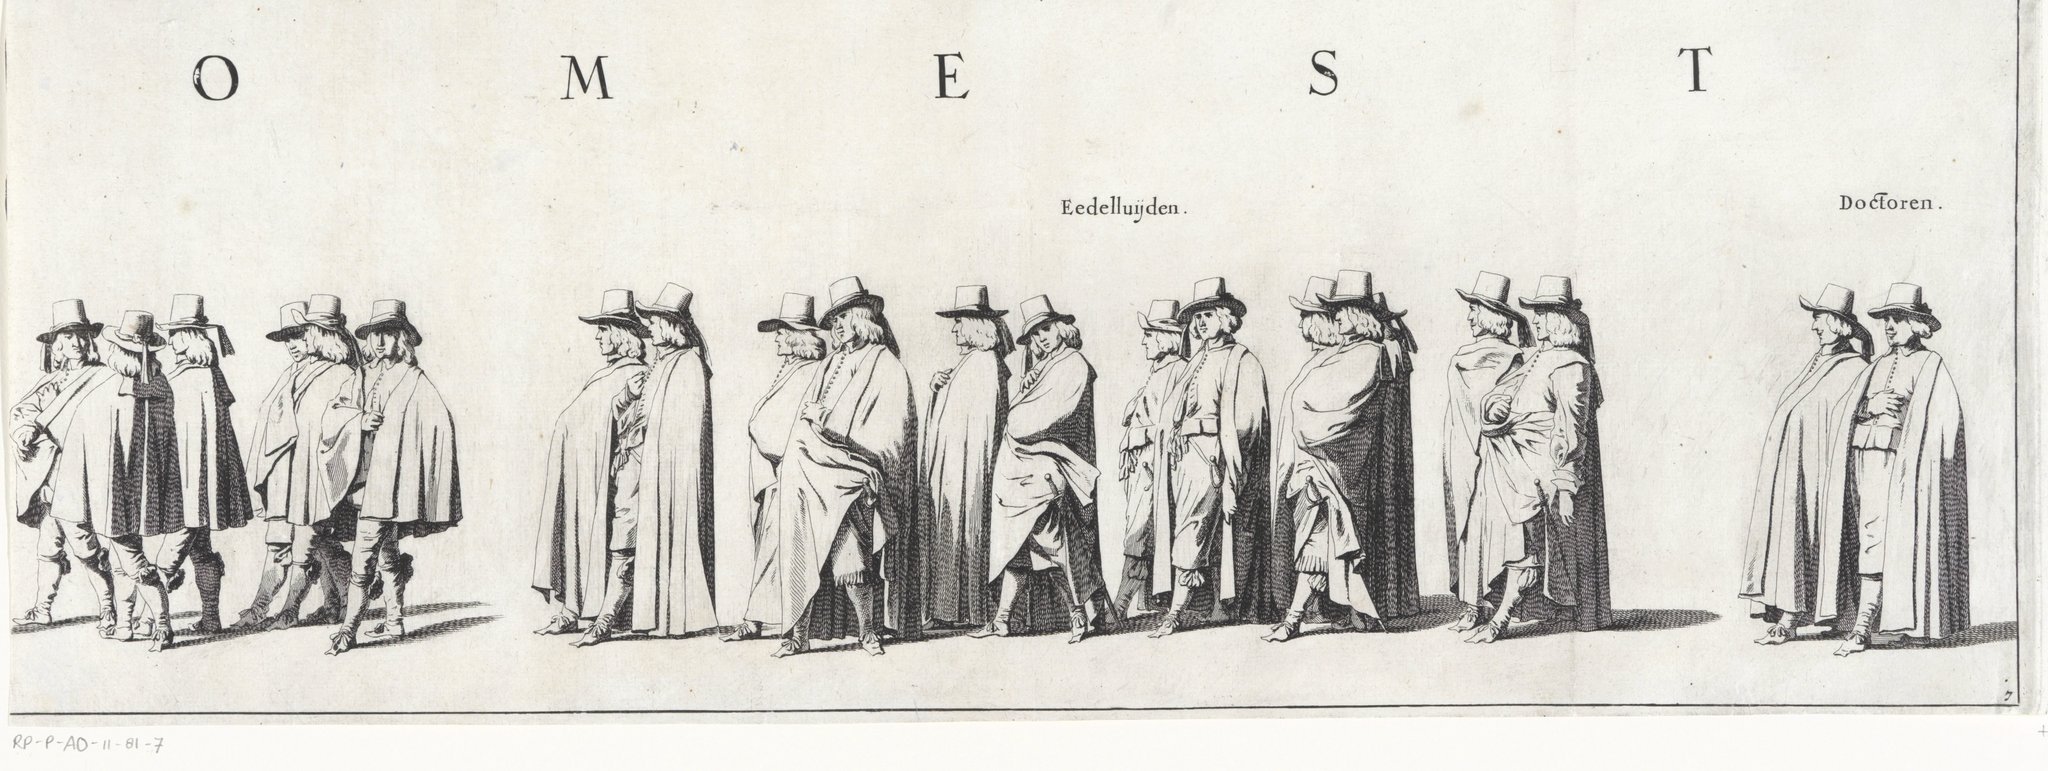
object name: print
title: De begrafenisstoet van Frederik Hendrik (plaat nr. 7), 1647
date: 1651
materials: paper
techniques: engraving, etching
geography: the hague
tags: cortege, funeral procession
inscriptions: collector's mark: Lugt 2228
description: De begrafenisstoet van stadhouder Frederik Hendrik te 's-Gravenhage op 10 mei 1647. Plaat nr. 7 met een deel van de stoet, boven de personen staat hun functie. Onderdeel van een serie van 30 platen en 20 tekstbladen, bedoeld om aan elkaar geplakt te worden.